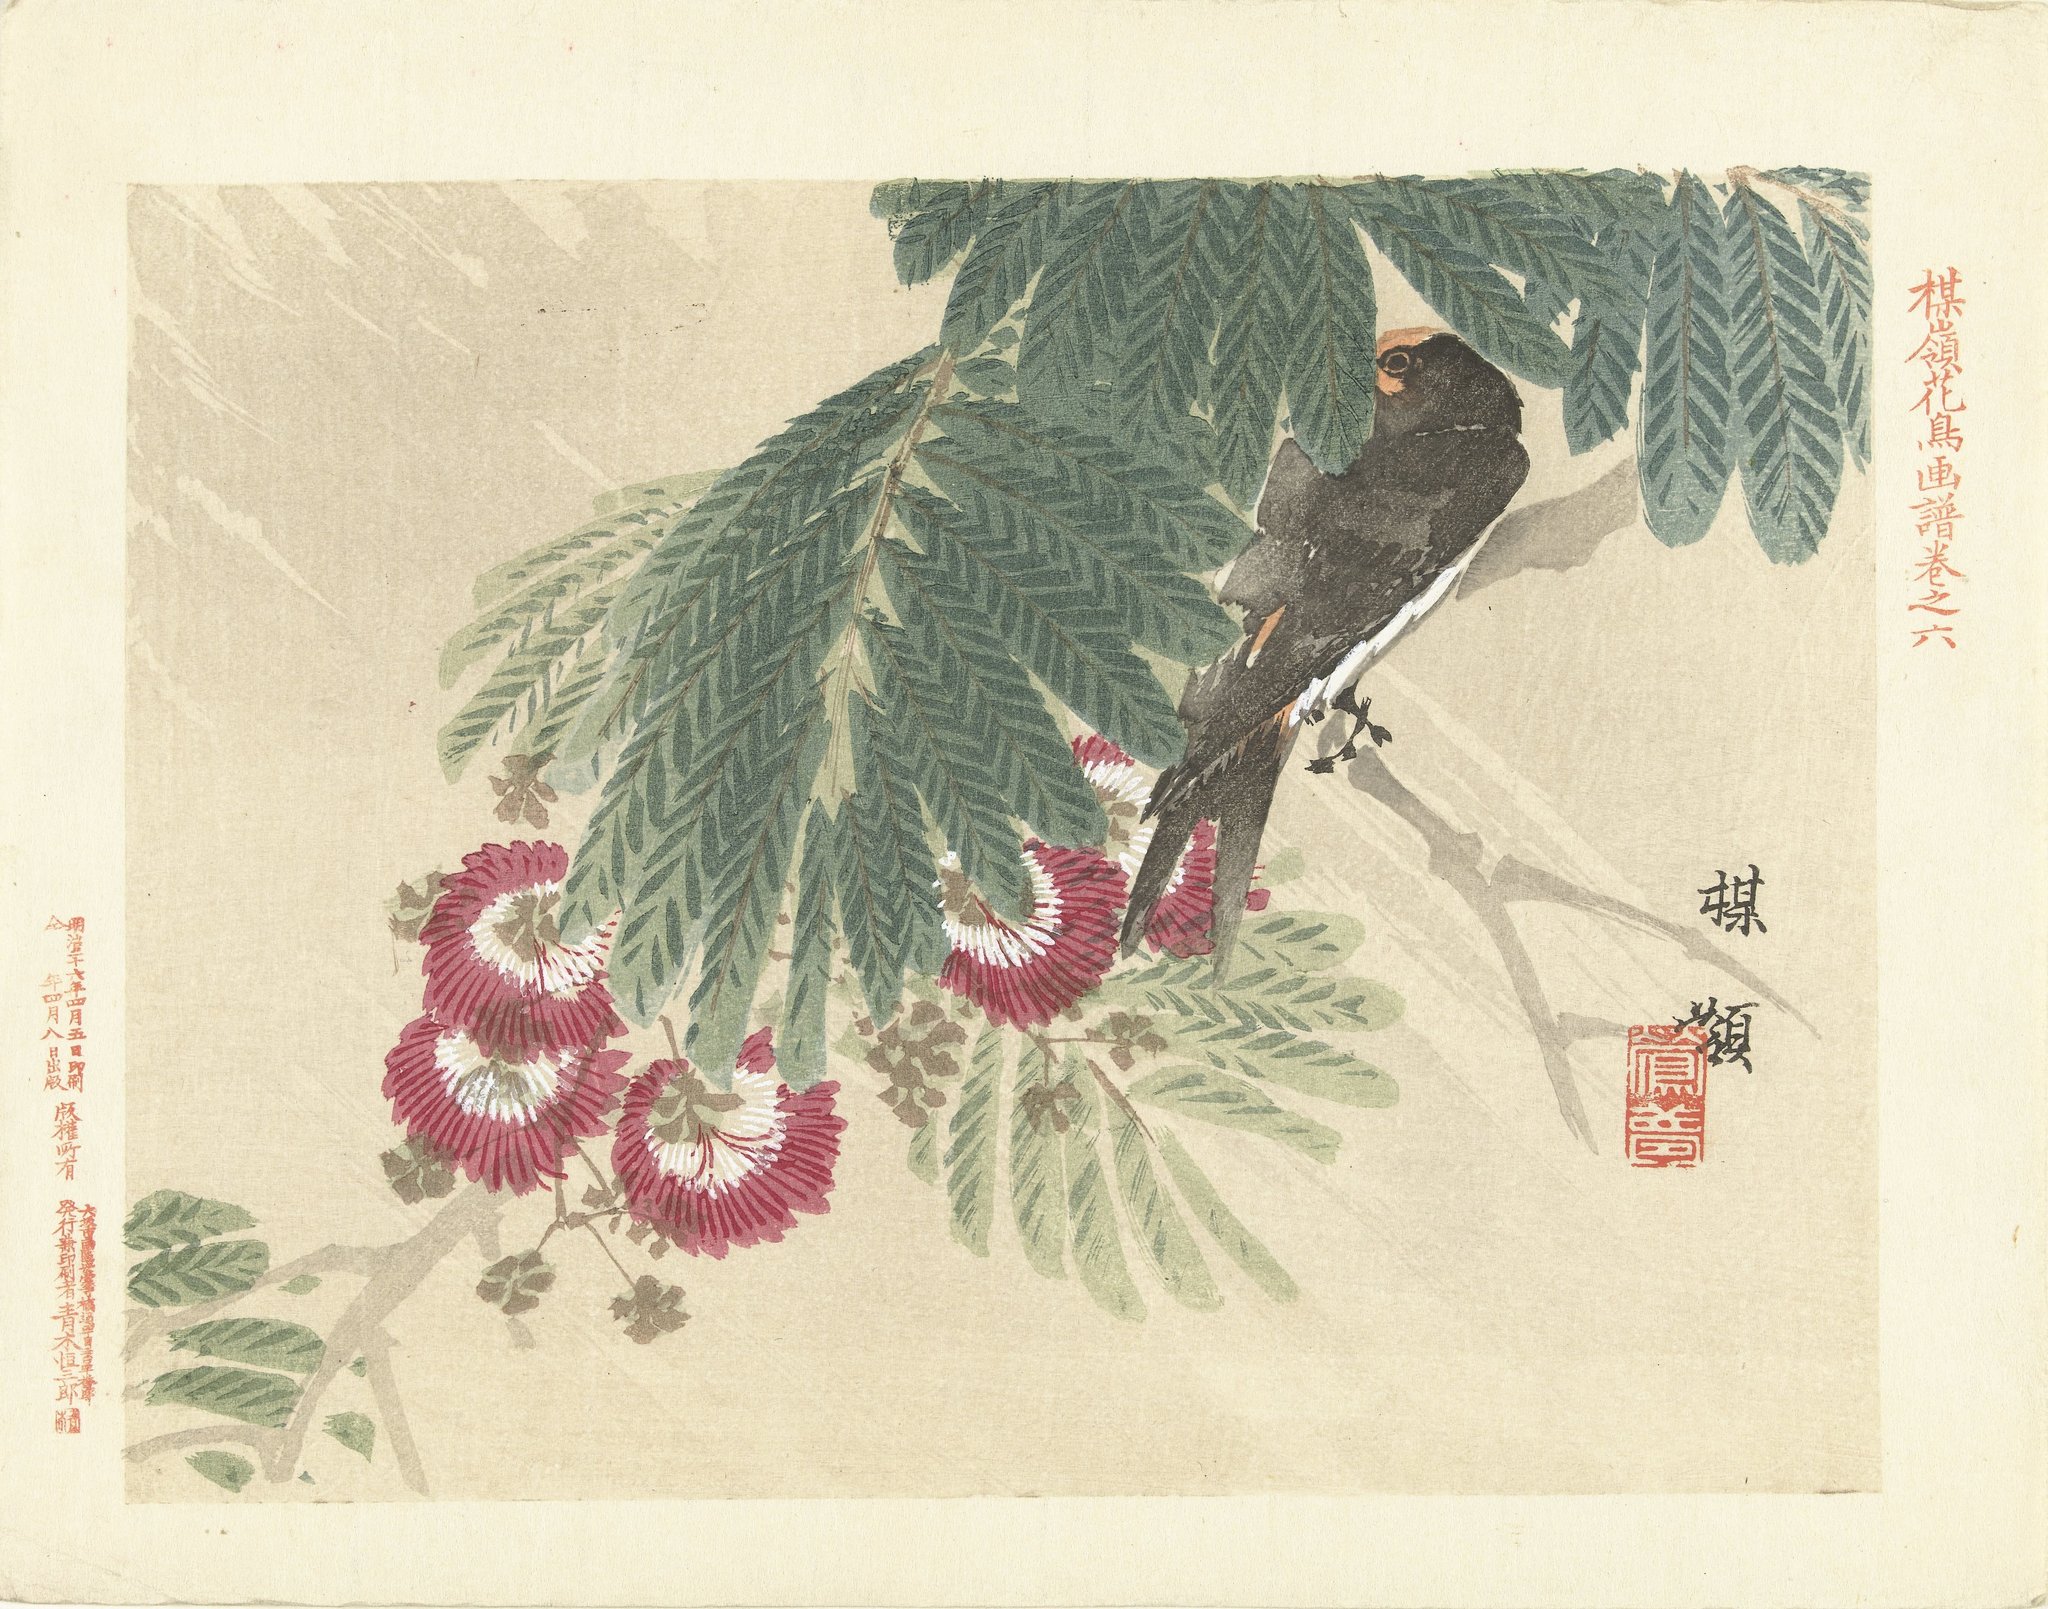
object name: print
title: Bairei`s bloemen- en vogelschetsen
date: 1804-1893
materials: paper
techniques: woodcut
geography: osaka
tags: plants; vegetation, song-birds: swallow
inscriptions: collector's mark: Lugt 2228, collector's mark: ‘Rijksschool voor kunstnijverheid’ Lugt 3937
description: Zwarte vogel op tak met groen blad en rood-witte bloemen.